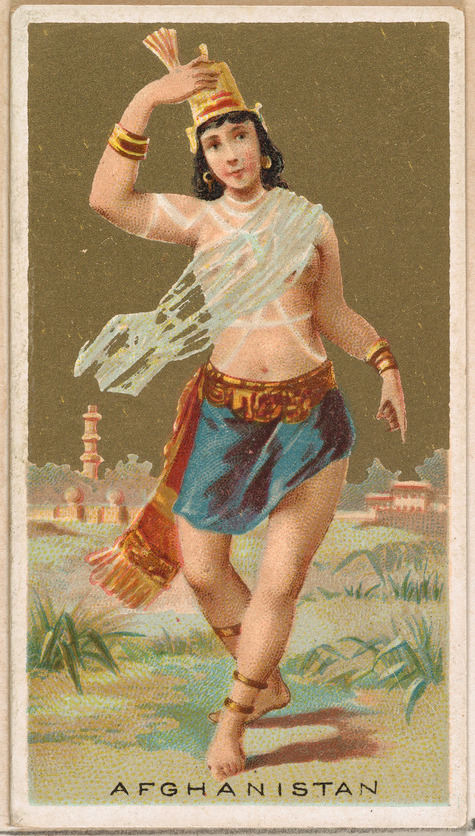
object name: print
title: Afghanistan, from the Dancing Girls of the World series (N185) issued by Wm. S. Kimball & Co.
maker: william s. kimball & company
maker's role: publisher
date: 1889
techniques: color lithograph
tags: women,dancing,dancers